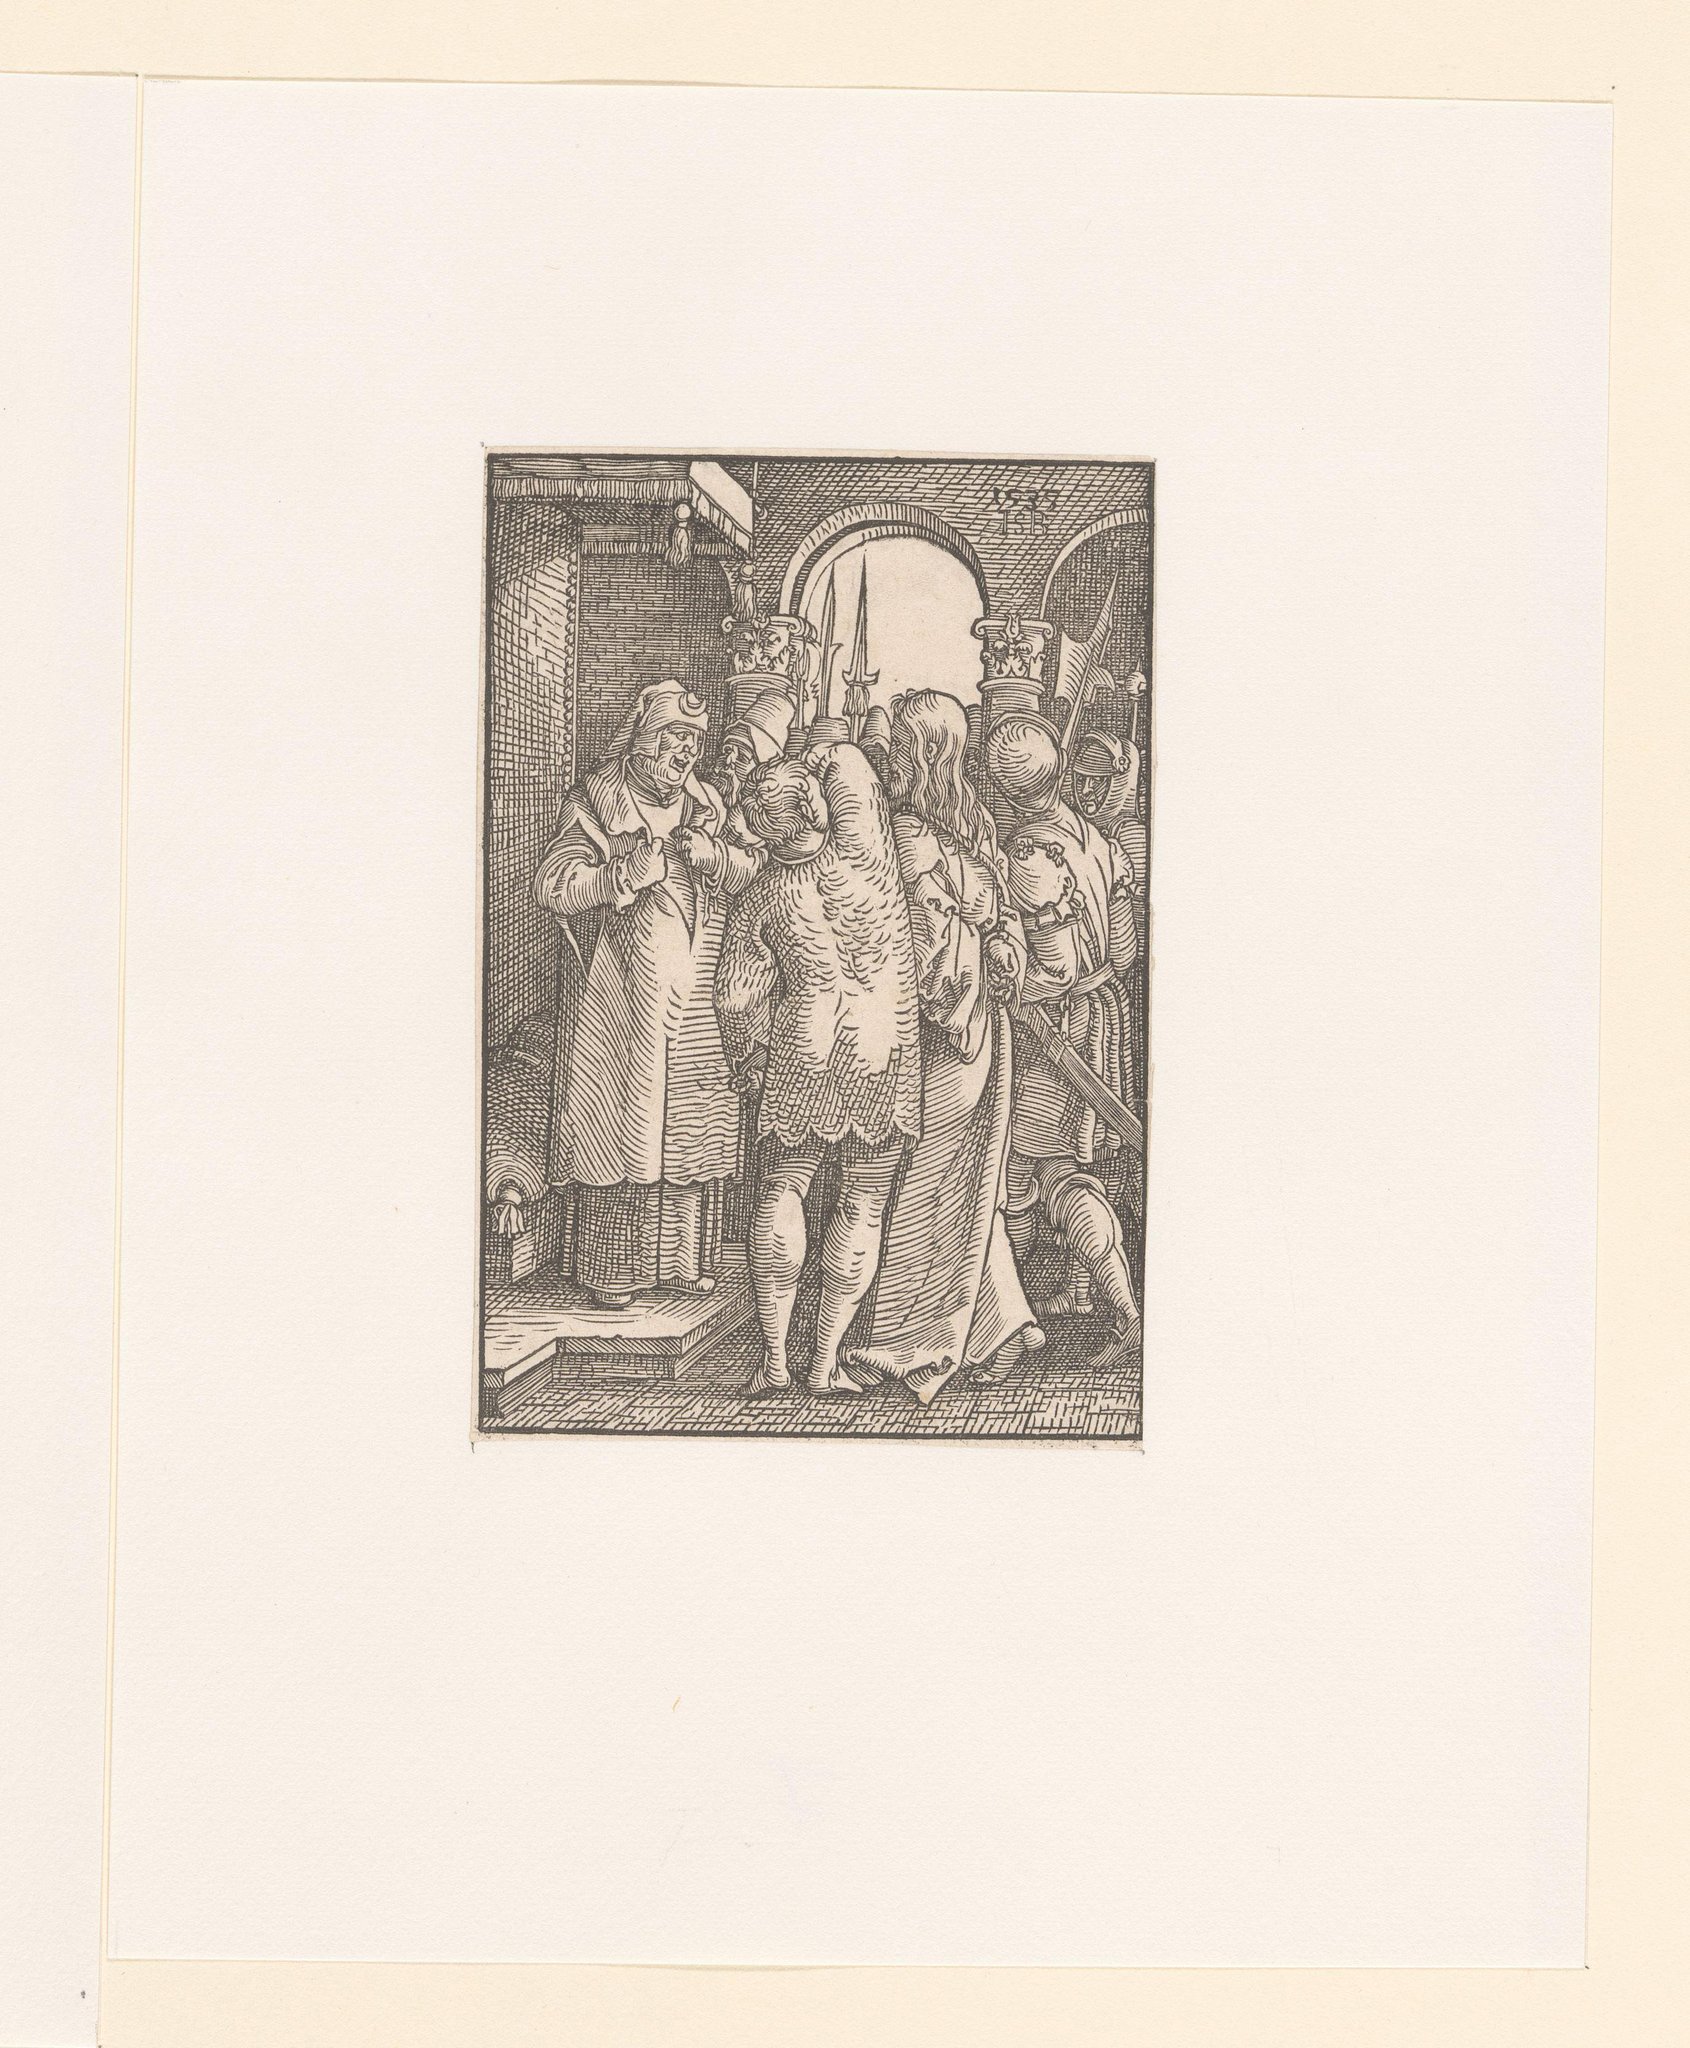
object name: print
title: Passie van Christus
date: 1535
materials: paper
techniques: woodcut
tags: caiaphas tearing his clothes ~ trial of christ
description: Onderdeel van een serie van acht prenten met de passie van Christus.